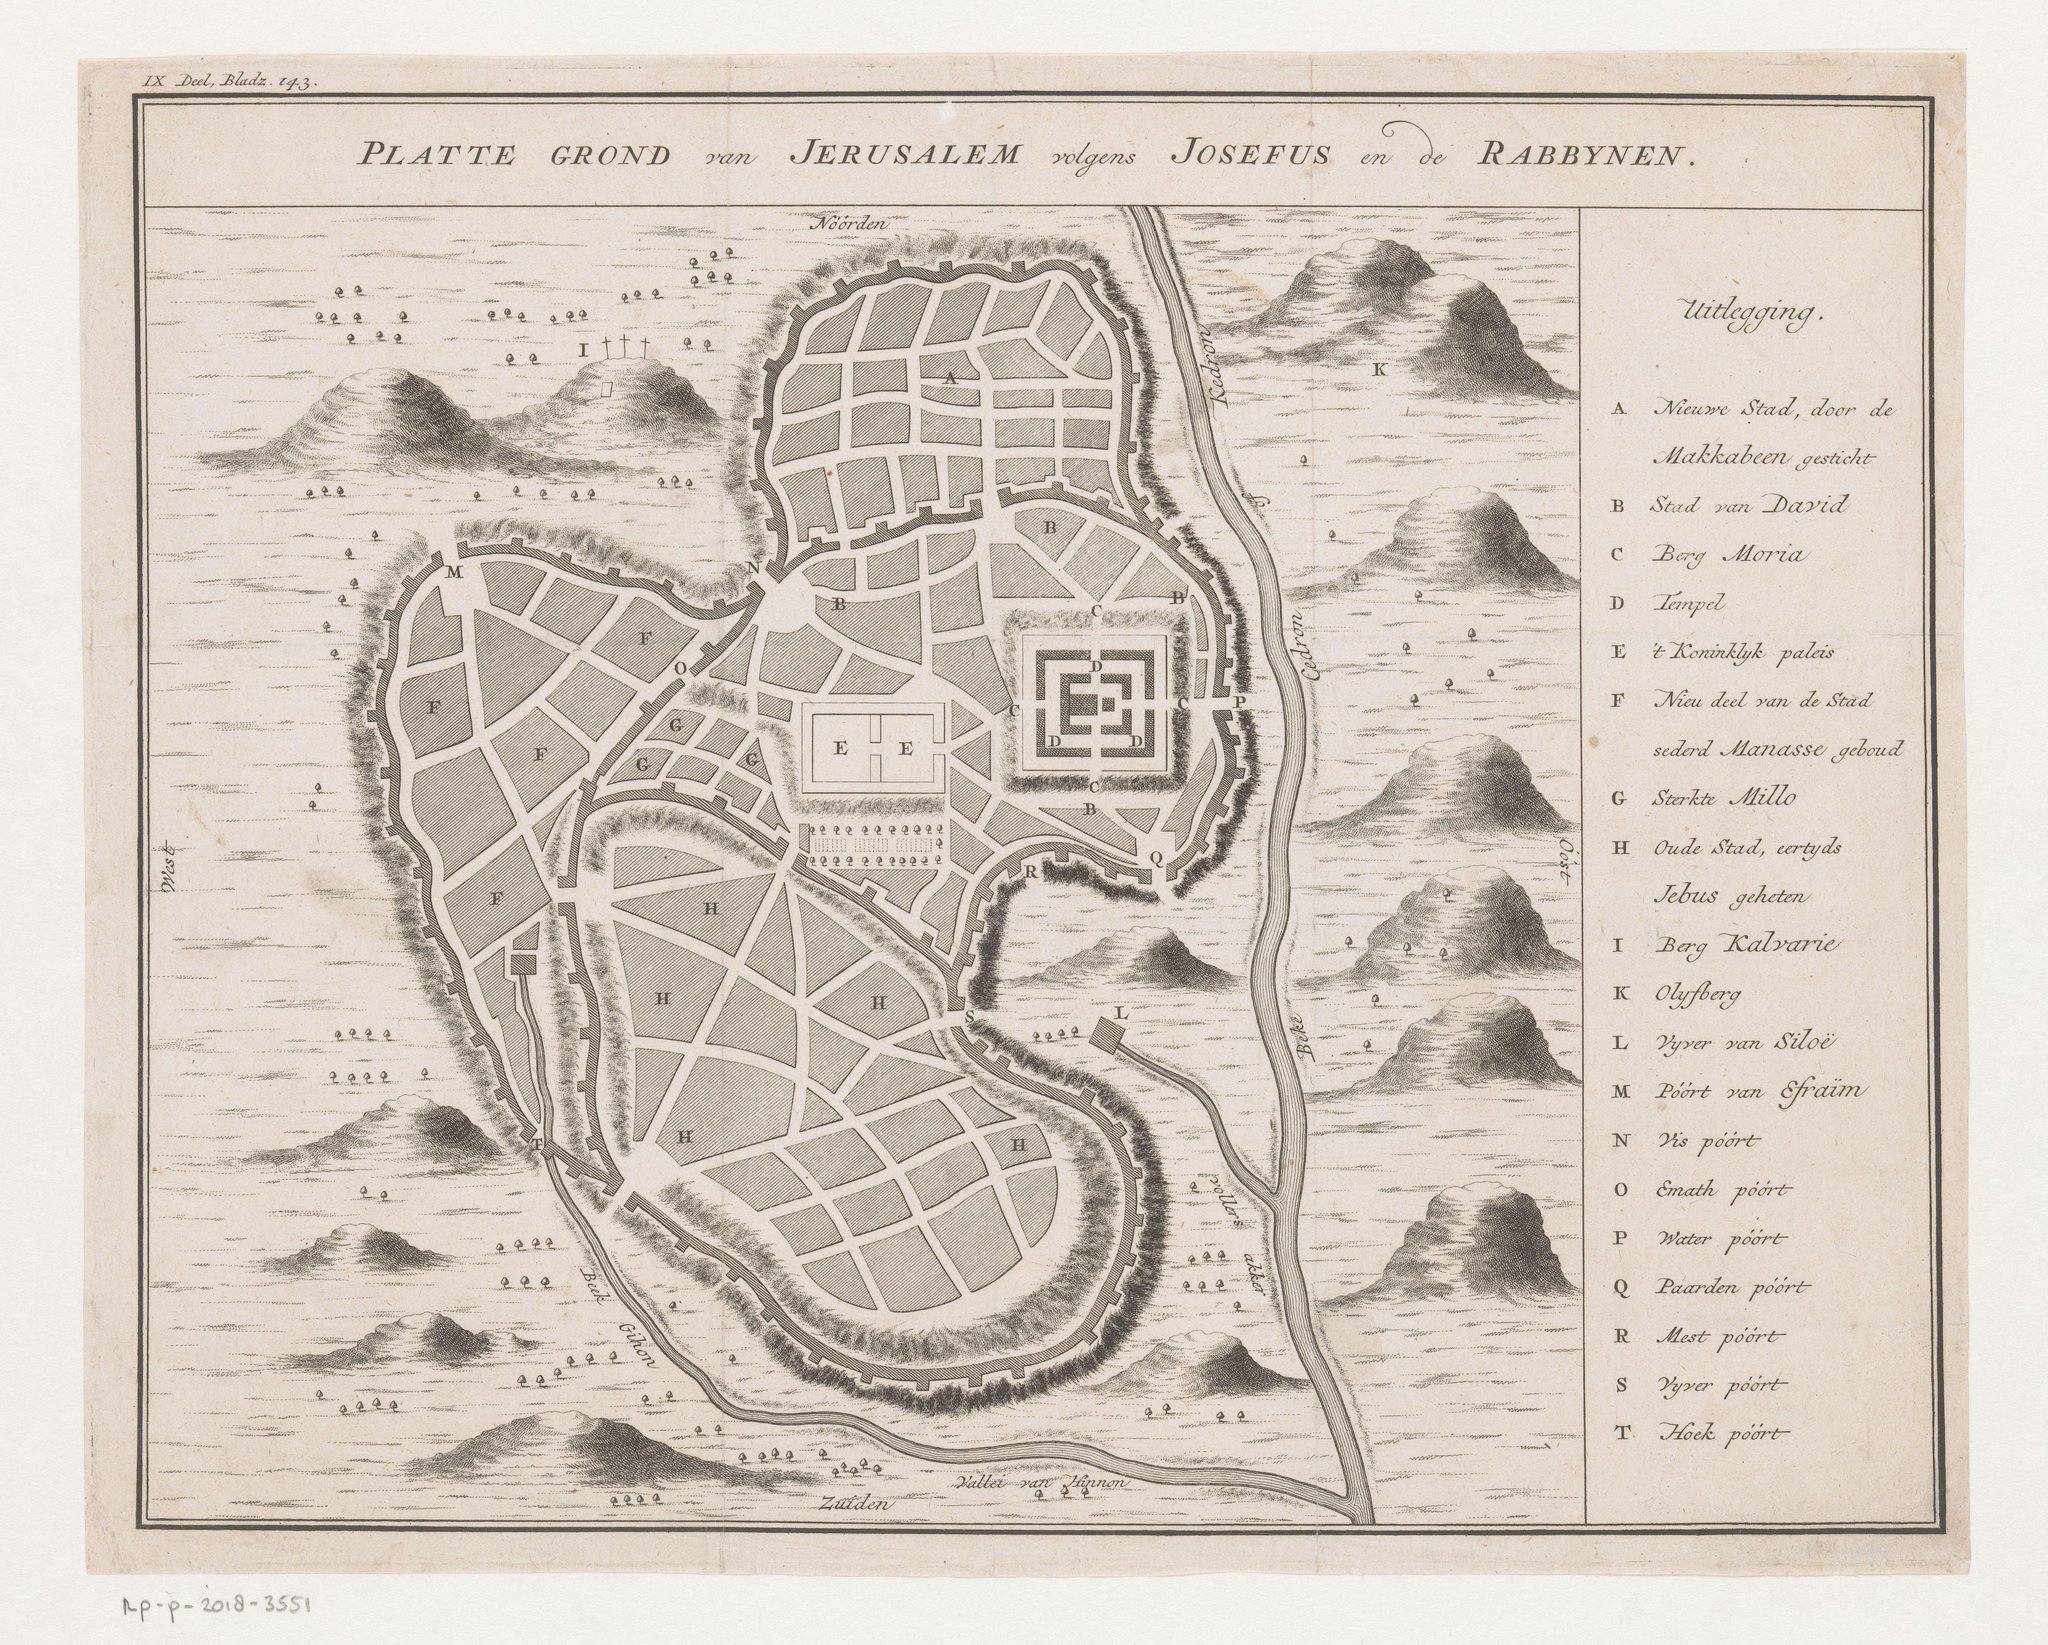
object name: map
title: Platte grond van Jerusalem volgens Josefus en de Rabbynen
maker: Anonymous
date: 1744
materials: paper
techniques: etching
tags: maps, atlases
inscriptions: collector's mark: Lugt 2228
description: Prent verschenen in: Westerbaen Willemsz., Kornelis. Algemeene histori beschreven door een gezelschap. Utrecht: Hermanus Besseling, 1744.